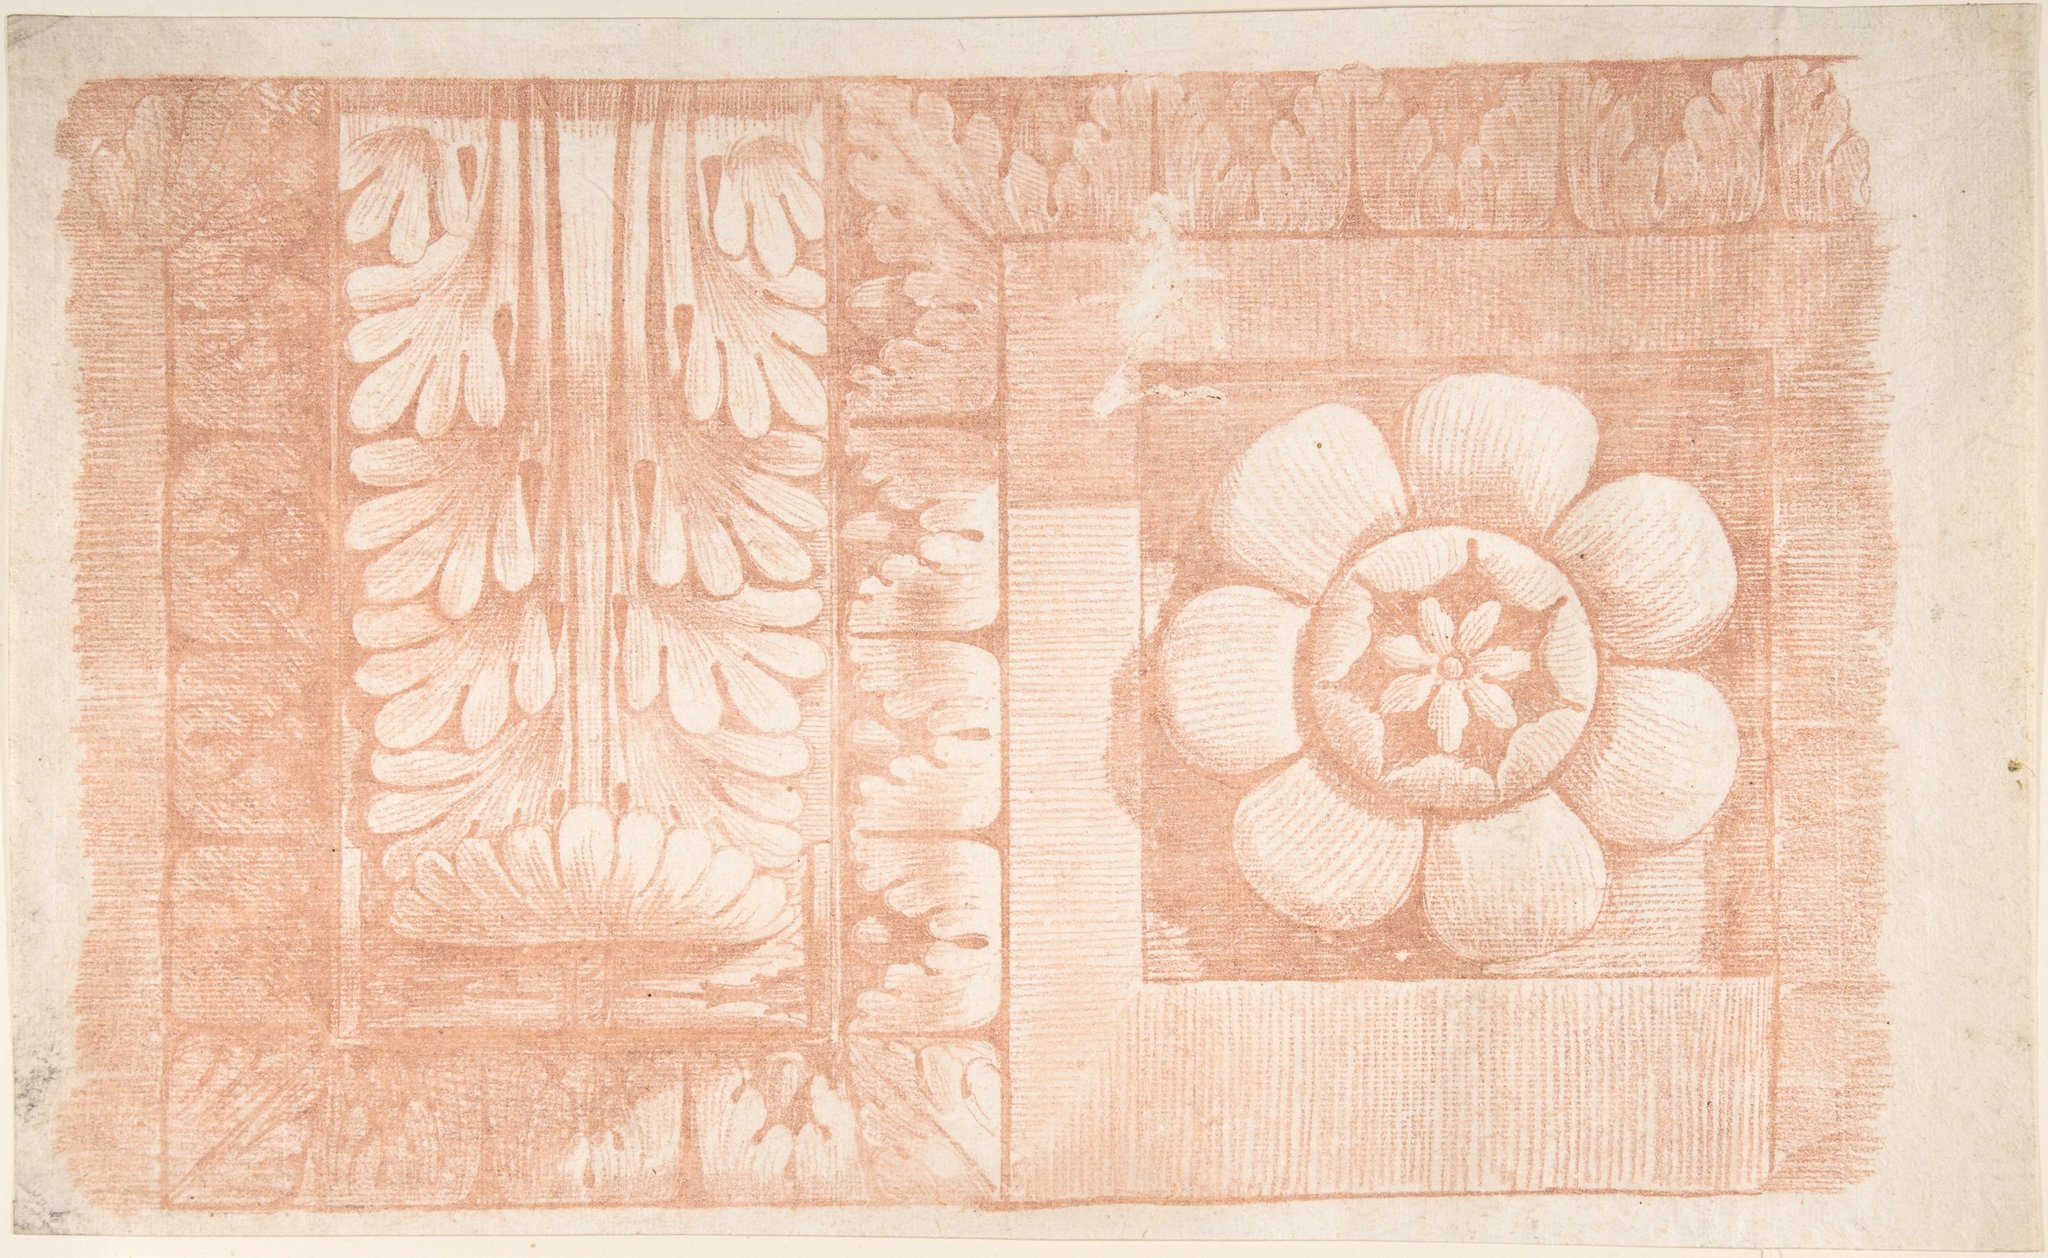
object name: drawing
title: Classical Molding with Floral Elements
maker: thomas hardwick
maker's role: artist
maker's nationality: british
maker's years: 1752-1829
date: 1776-1779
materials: chalk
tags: flowers